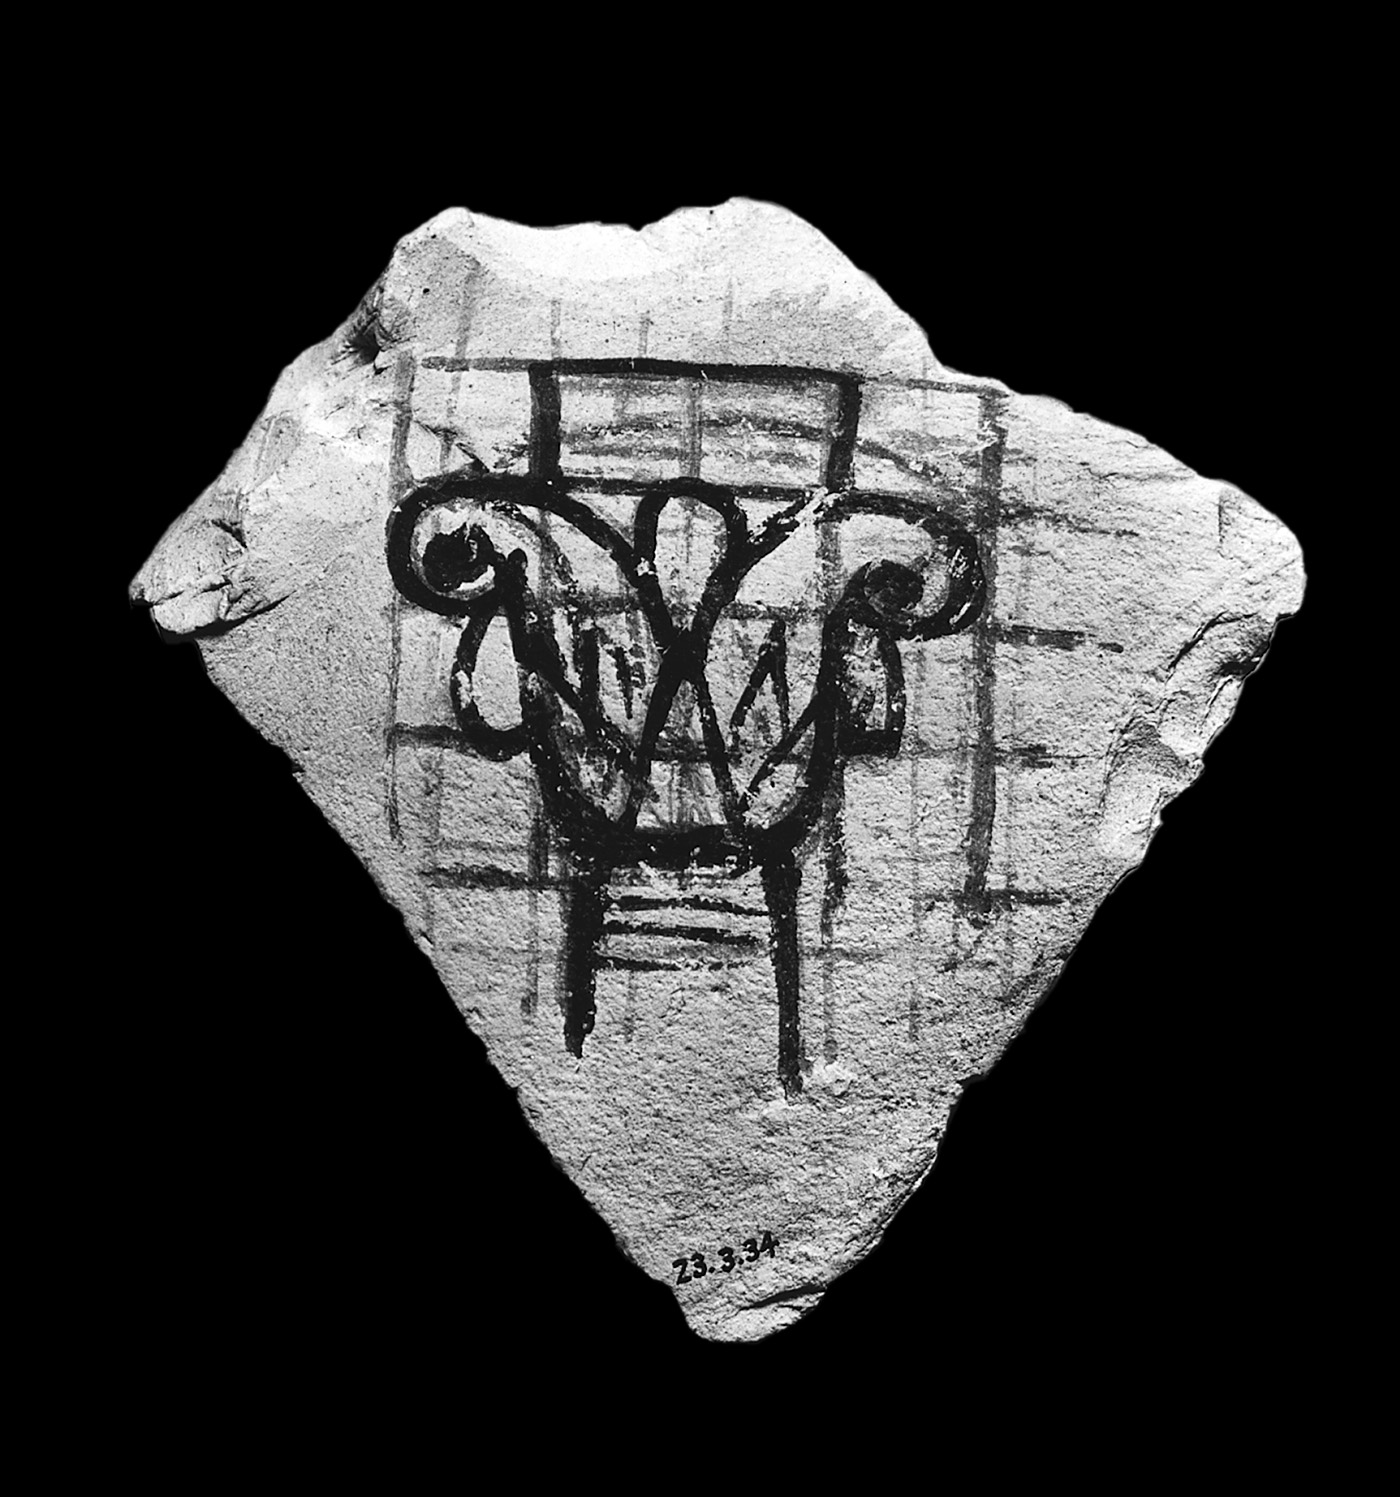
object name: ostracon, figured, lotus capital, grid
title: Ostracon with liliform capital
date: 664-610 BCE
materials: ink, limestone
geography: egypt